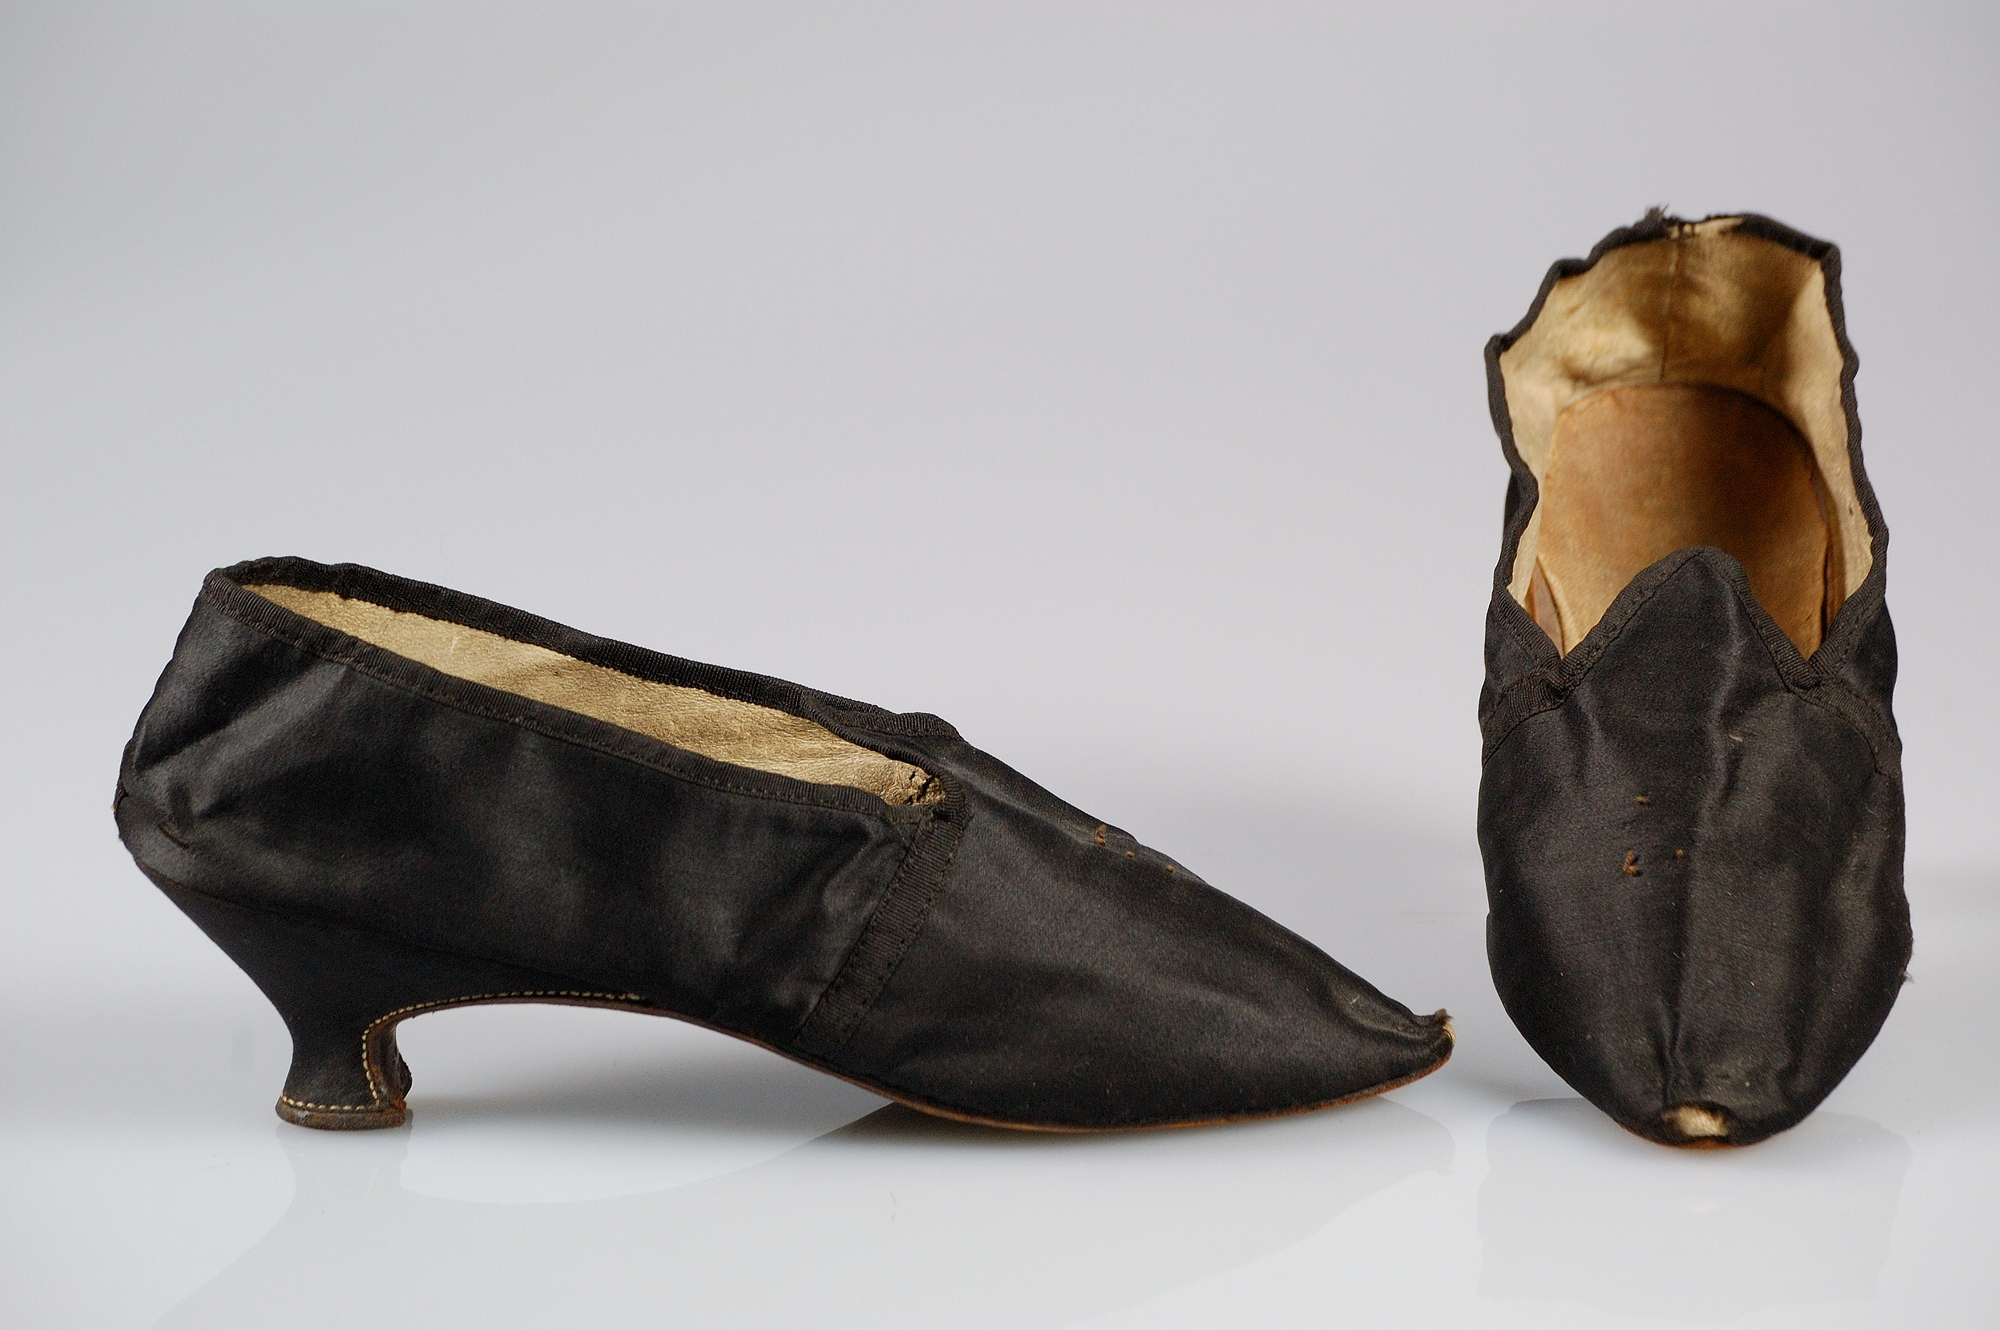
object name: slipper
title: Slippers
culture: european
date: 1775-1795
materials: silk